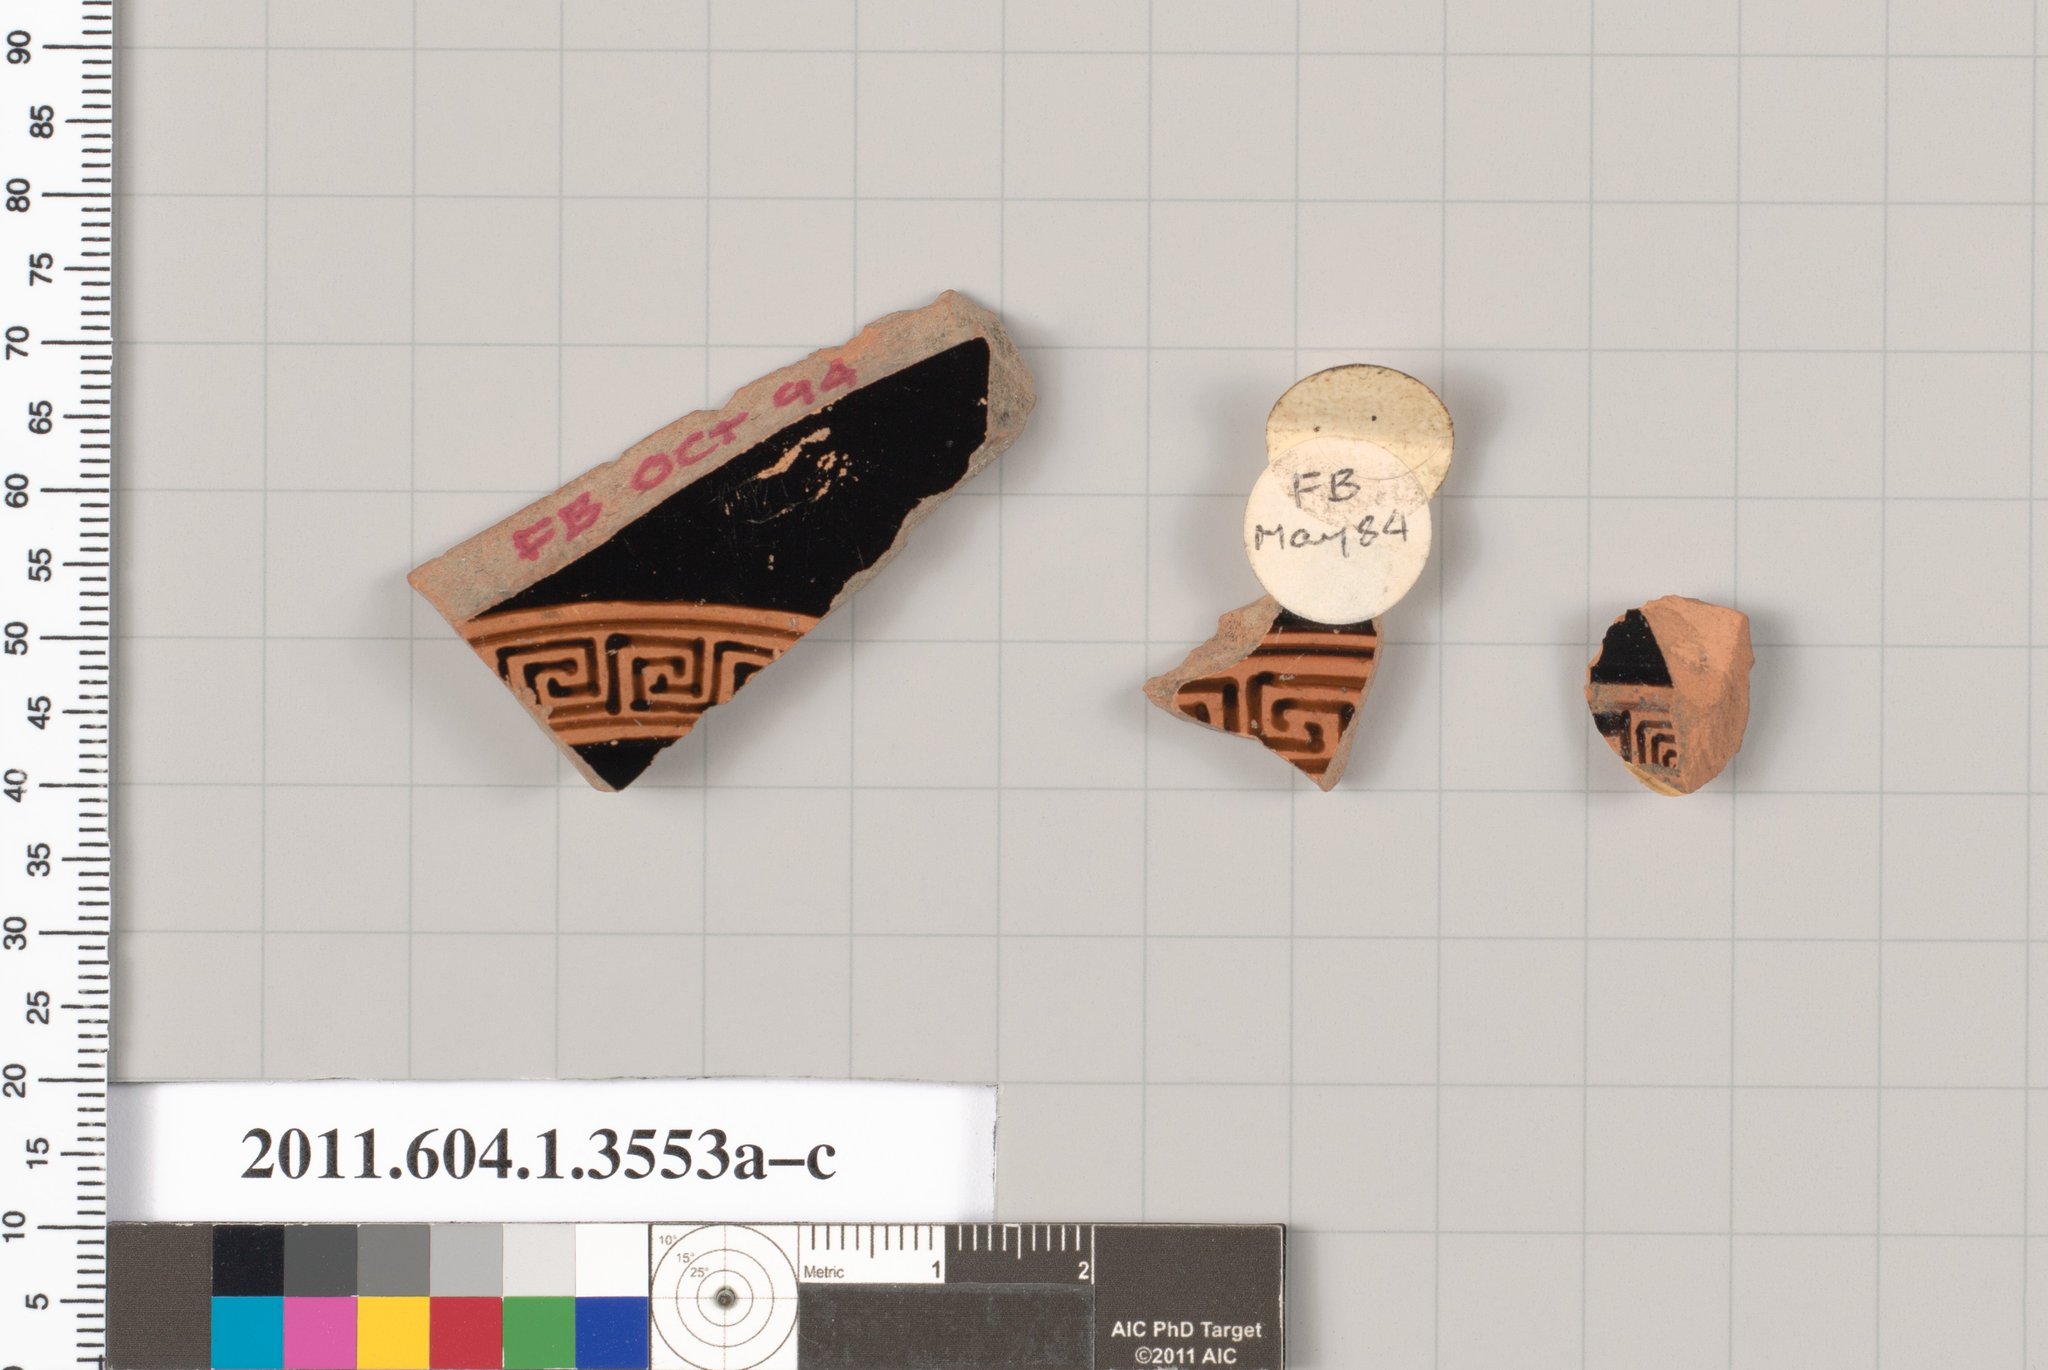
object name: kylix fragment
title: Terracotta fragments of kylikes (drinking cups)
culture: greek, attic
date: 510-490 BCE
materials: terracotta